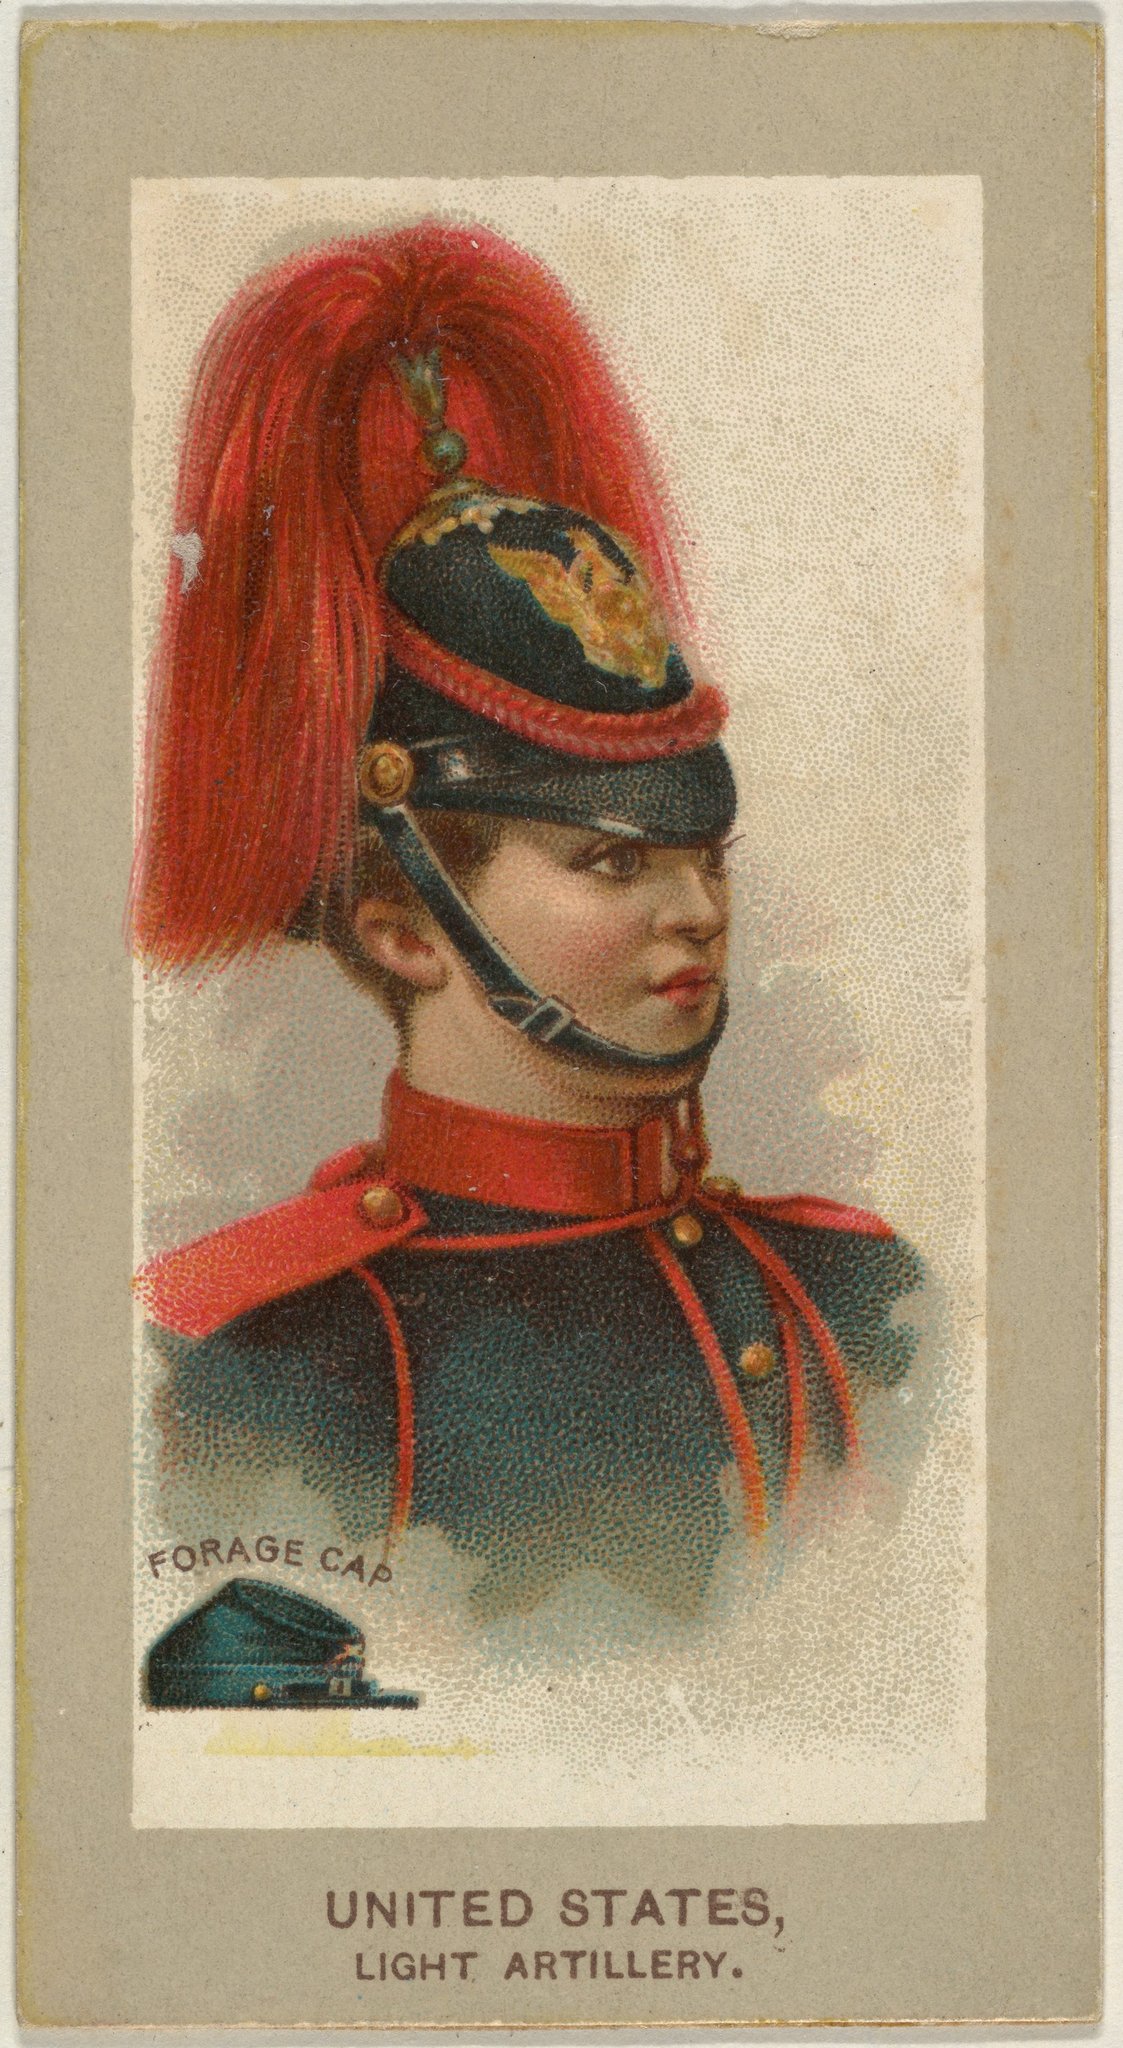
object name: print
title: Forage Cap, Light Artillery, United States, from the Military Uniforms series (T182) issued by Abdul Cigarettes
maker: abdul cigarettes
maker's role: publisher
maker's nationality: american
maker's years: 1881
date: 1881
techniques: color lithograph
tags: men